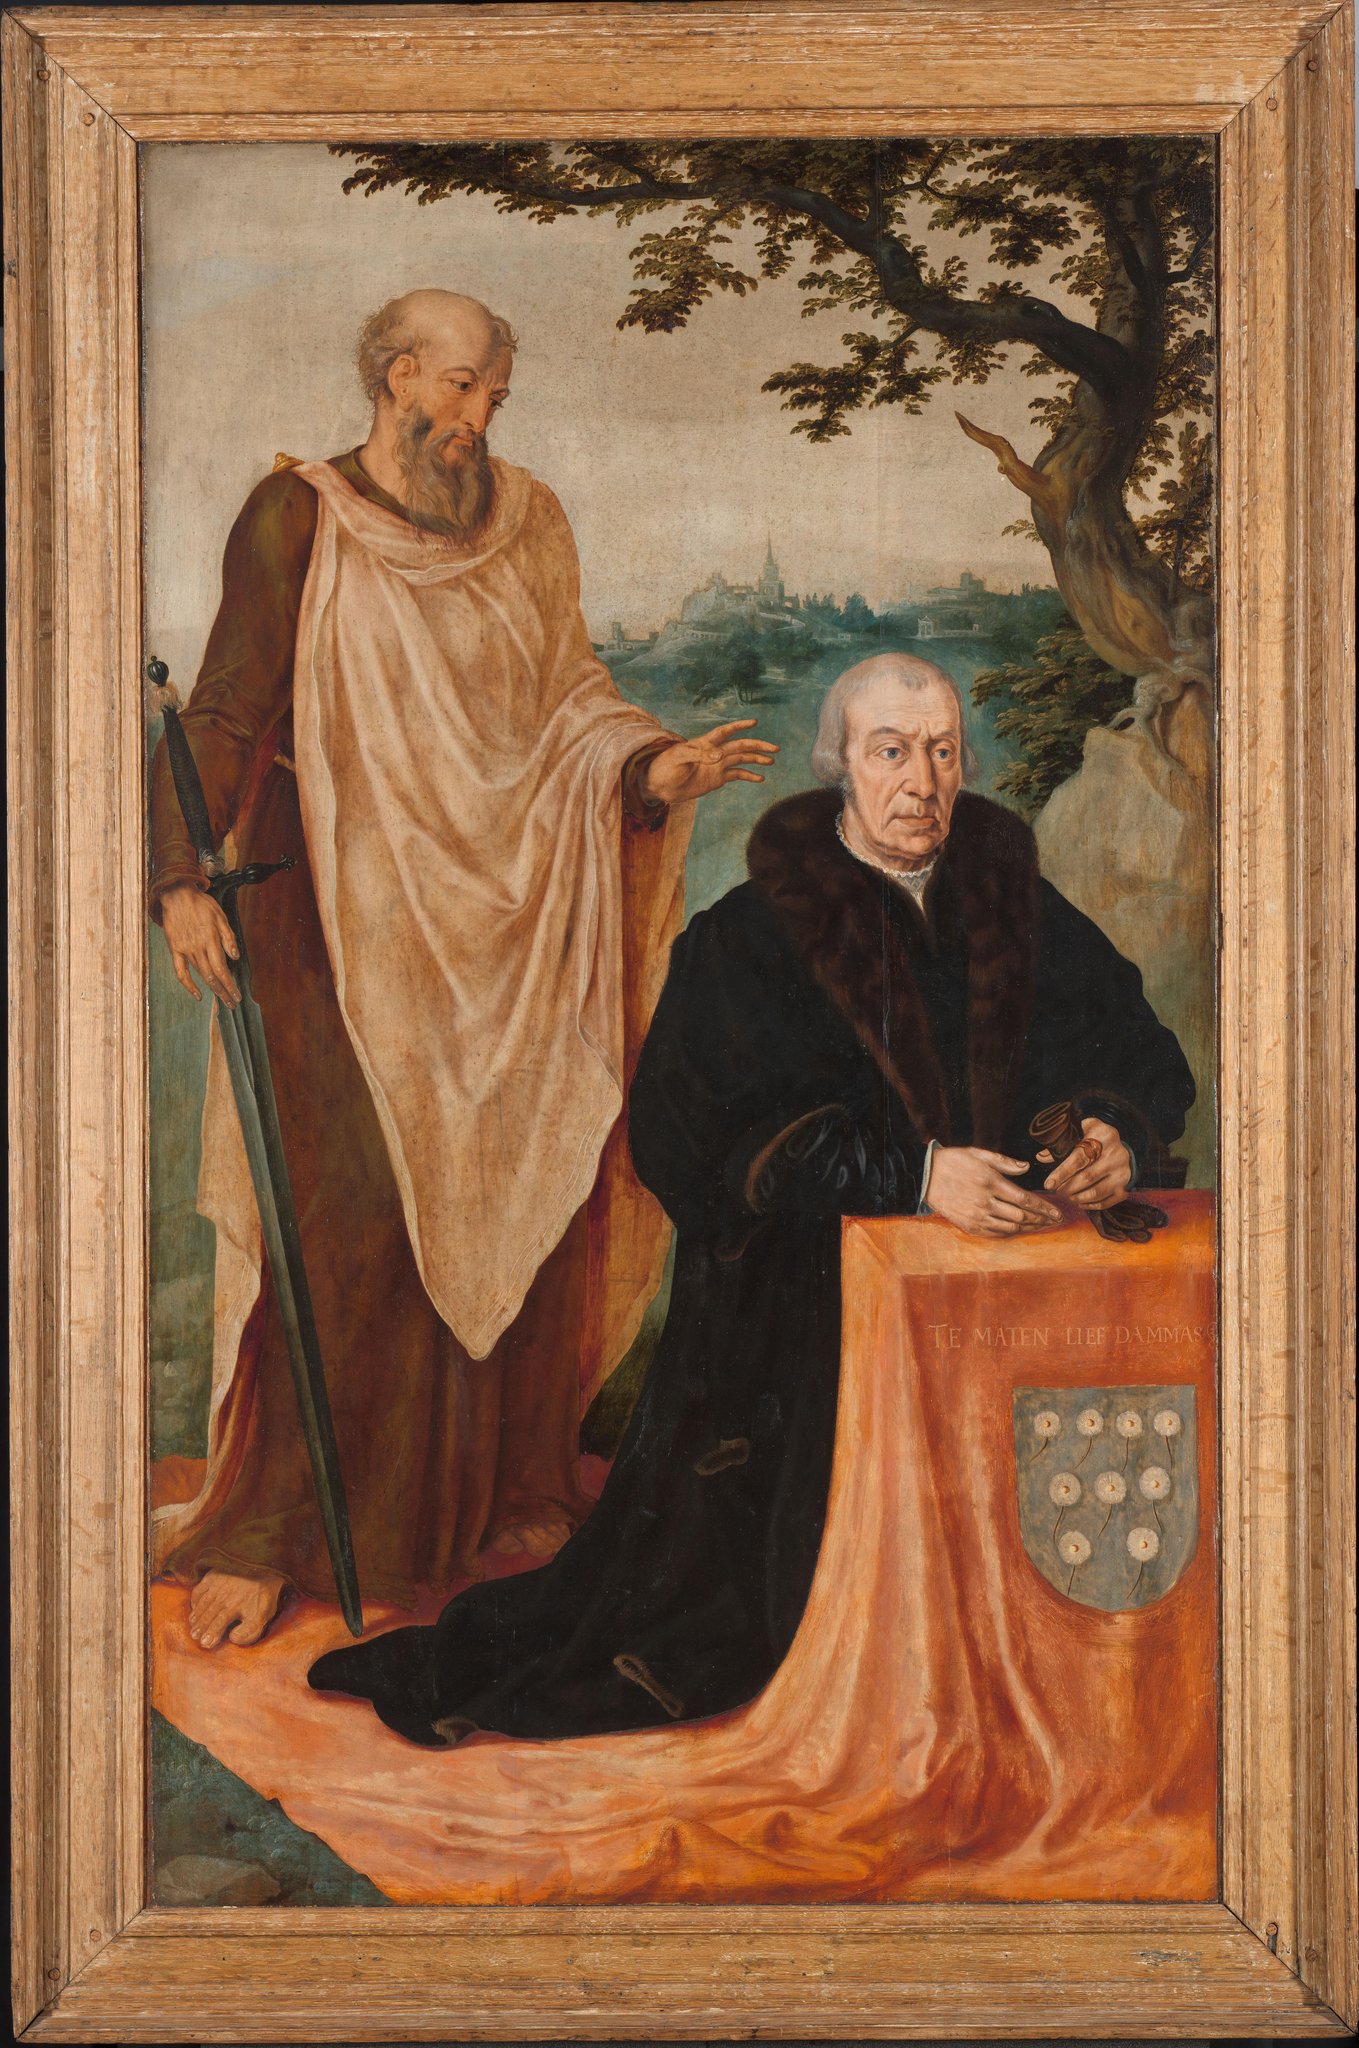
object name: zijpaneel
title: Sibylla Erythrea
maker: martinus van heemskerck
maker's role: draughtsman, painter, print maker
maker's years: 1498-1574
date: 1564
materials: oil, panel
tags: erythraean sibyl, the apostle paul of tarsus; possible attributes: book, scroll, sword, kneeling on both knees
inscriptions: inscription, outer wing, centre left, in the book: ‘SYBYLLA ERYTHREA’, coat of arms, inner wing, lower right, on the prie-dieu: ‘nine daisies, four above three above two, on a blue field’, signature, outer wing, bottom left: ‘Maertynus van Heemskerck, inventor’, date, outer wing, bottom left: ‘Aº 1564’, inscription, inner wing, lower right, on the prie-dieu: ‘TE MATEN LIEF DAMMASZ’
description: The Erythraean Sybil was a prophetess of classical antiquity who foretold the coming of Christ. Heemskerck depicted her here, on this left wing of a large altarpiece, as a young woman attired in fantasy clothing. The paint layer has become discoloured and transparent in places, whereby the underdrawing shines through the gown.